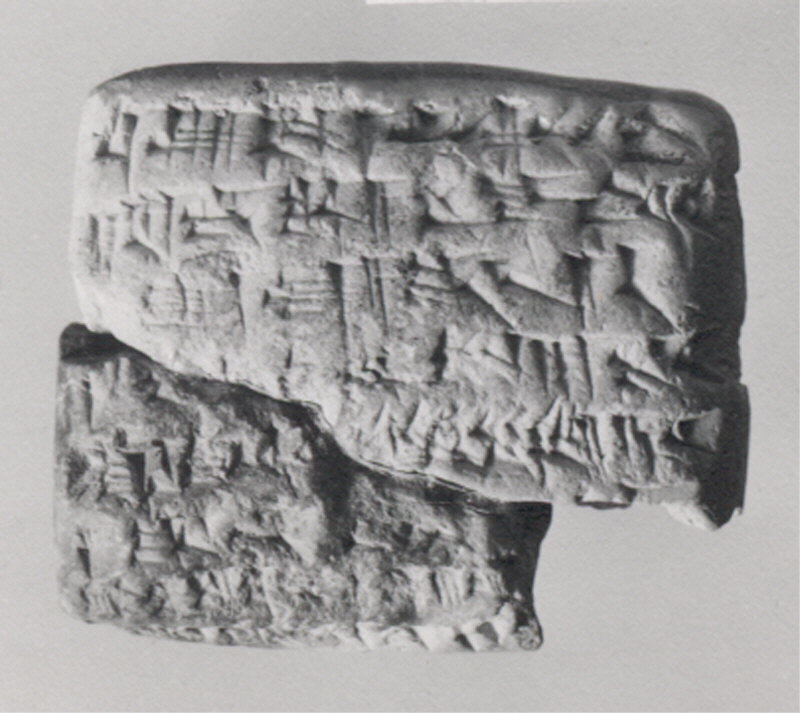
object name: cuneiform tablet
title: Cuneiform tablet: receipt for silver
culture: achaemenid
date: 537 BCE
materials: clay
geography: mesopotamia